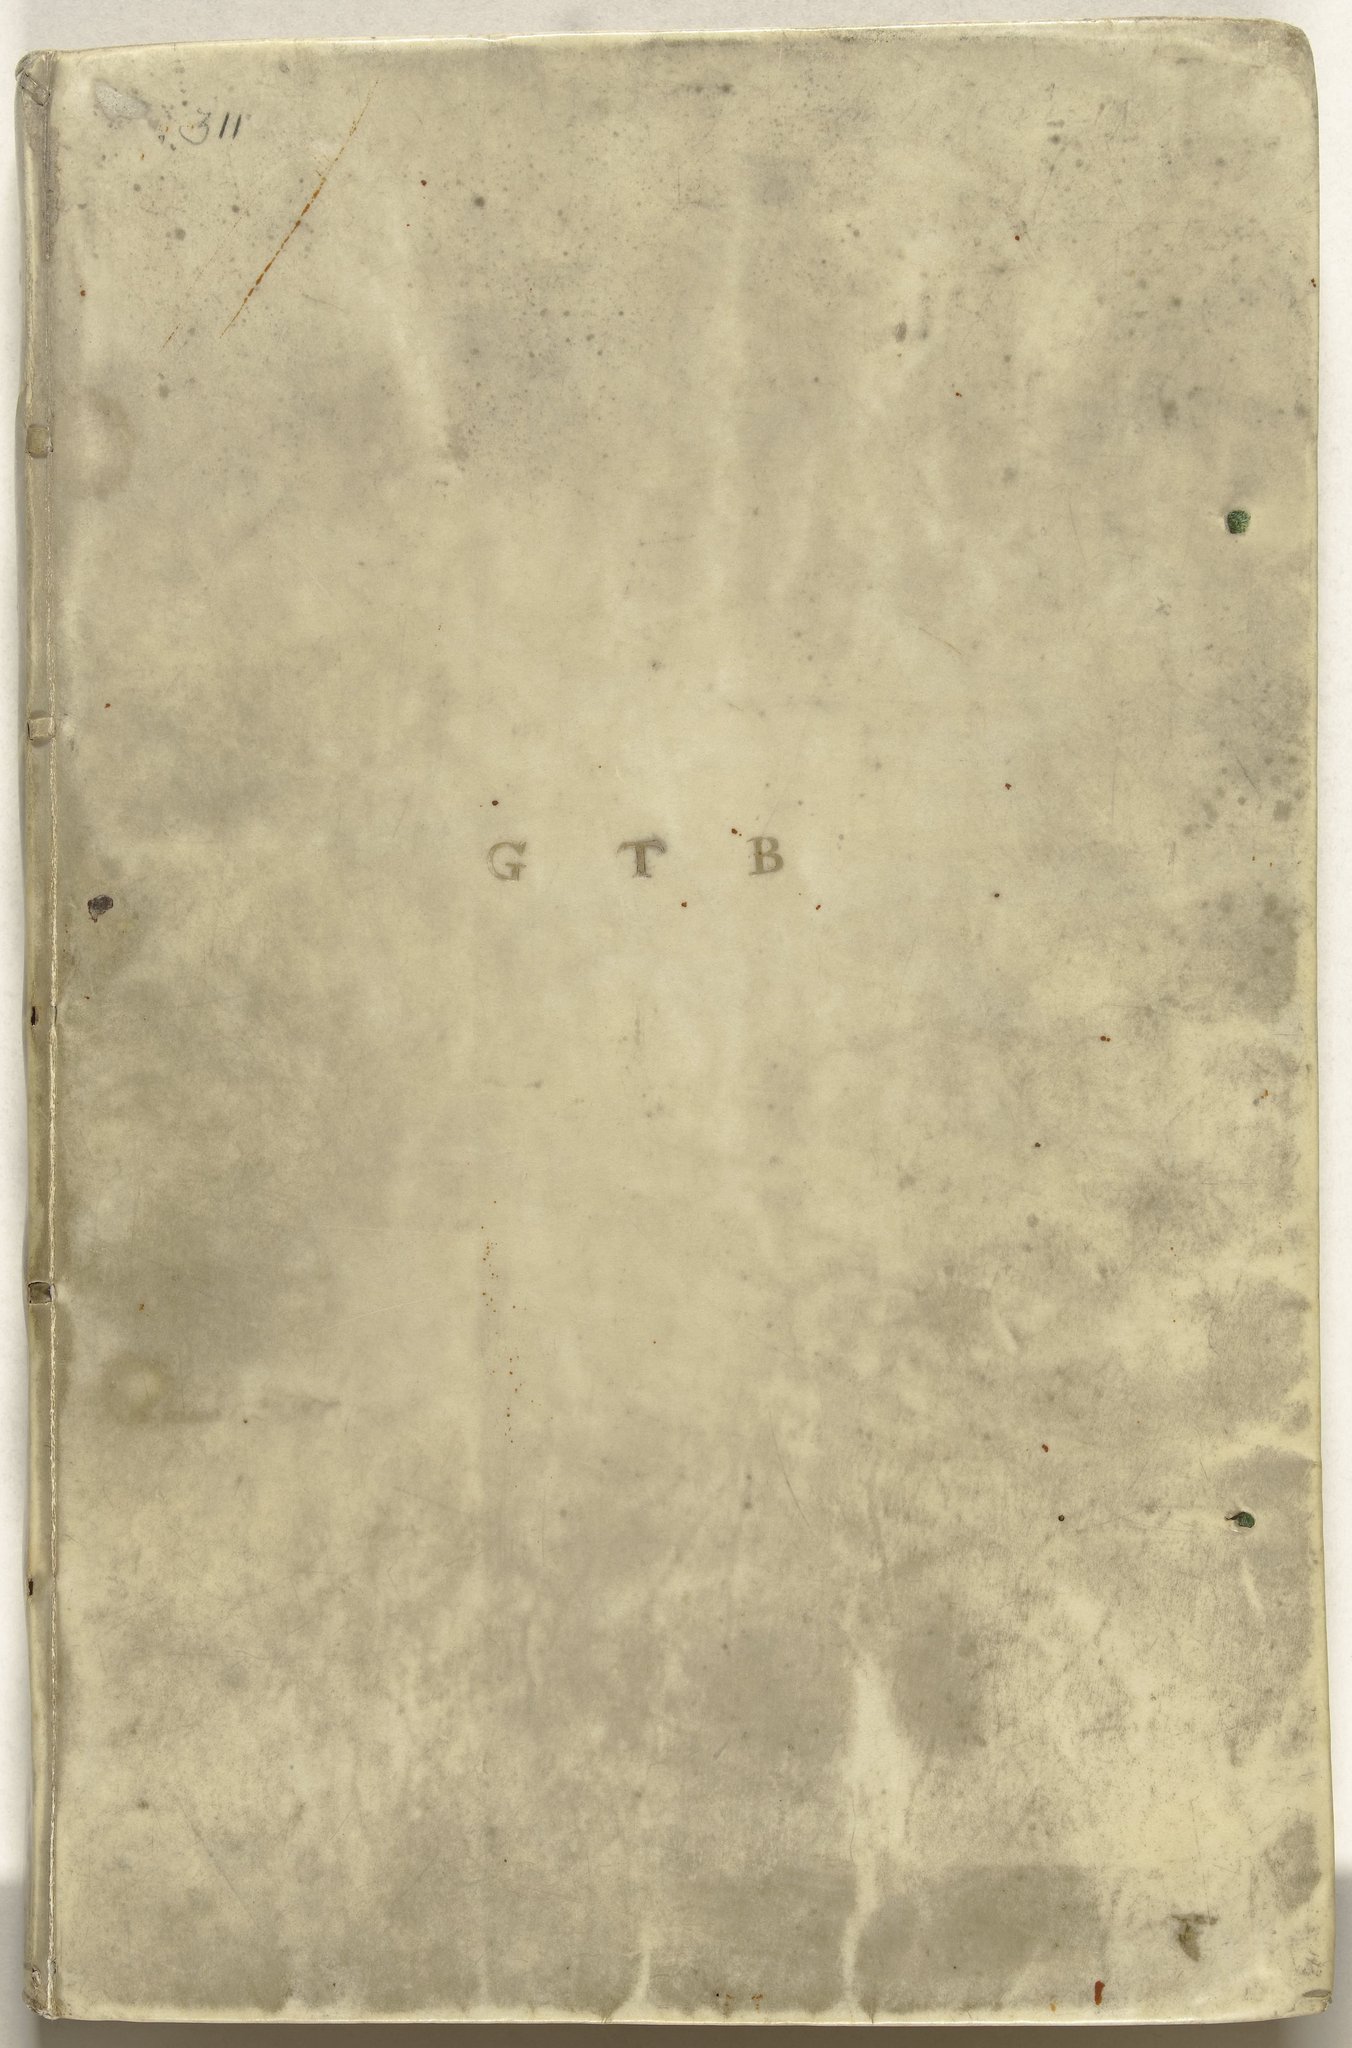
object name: album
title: Self-Portrait in a Cartouche with the Ter Borch Family Coat of Arms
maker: gesina ter borch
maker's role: draughtsman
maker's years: 1633-1690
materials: leather, gold leaf, paper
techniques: bookbinding, gilding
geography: zwolle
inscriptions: number: ‘311’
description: Gesina ter Borch placed this self-portrait at the beginning of her Poëzie-album (Poetry Album), consisting of over 90 poems to be sung accompanied by delicate watercolour drawings. Such handwritten, illustrated songbooks are very rare. This album testifies to Ter Borch’s boundless inventiveness and ambition. Beneath the self-portrait, a schoolmaster not surprisingly sang the praises of both her ‘konstrijcke hant’ (artistic hand) and her ‘geestrijck verstant’ (brilliant mind).